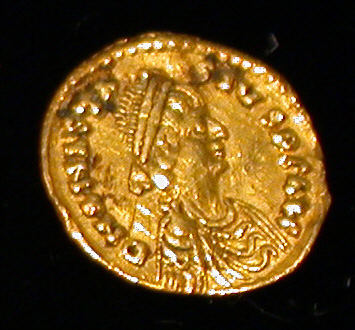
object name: coin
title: Semissis of Anastasius I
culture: byzantine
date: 491-518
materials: gold